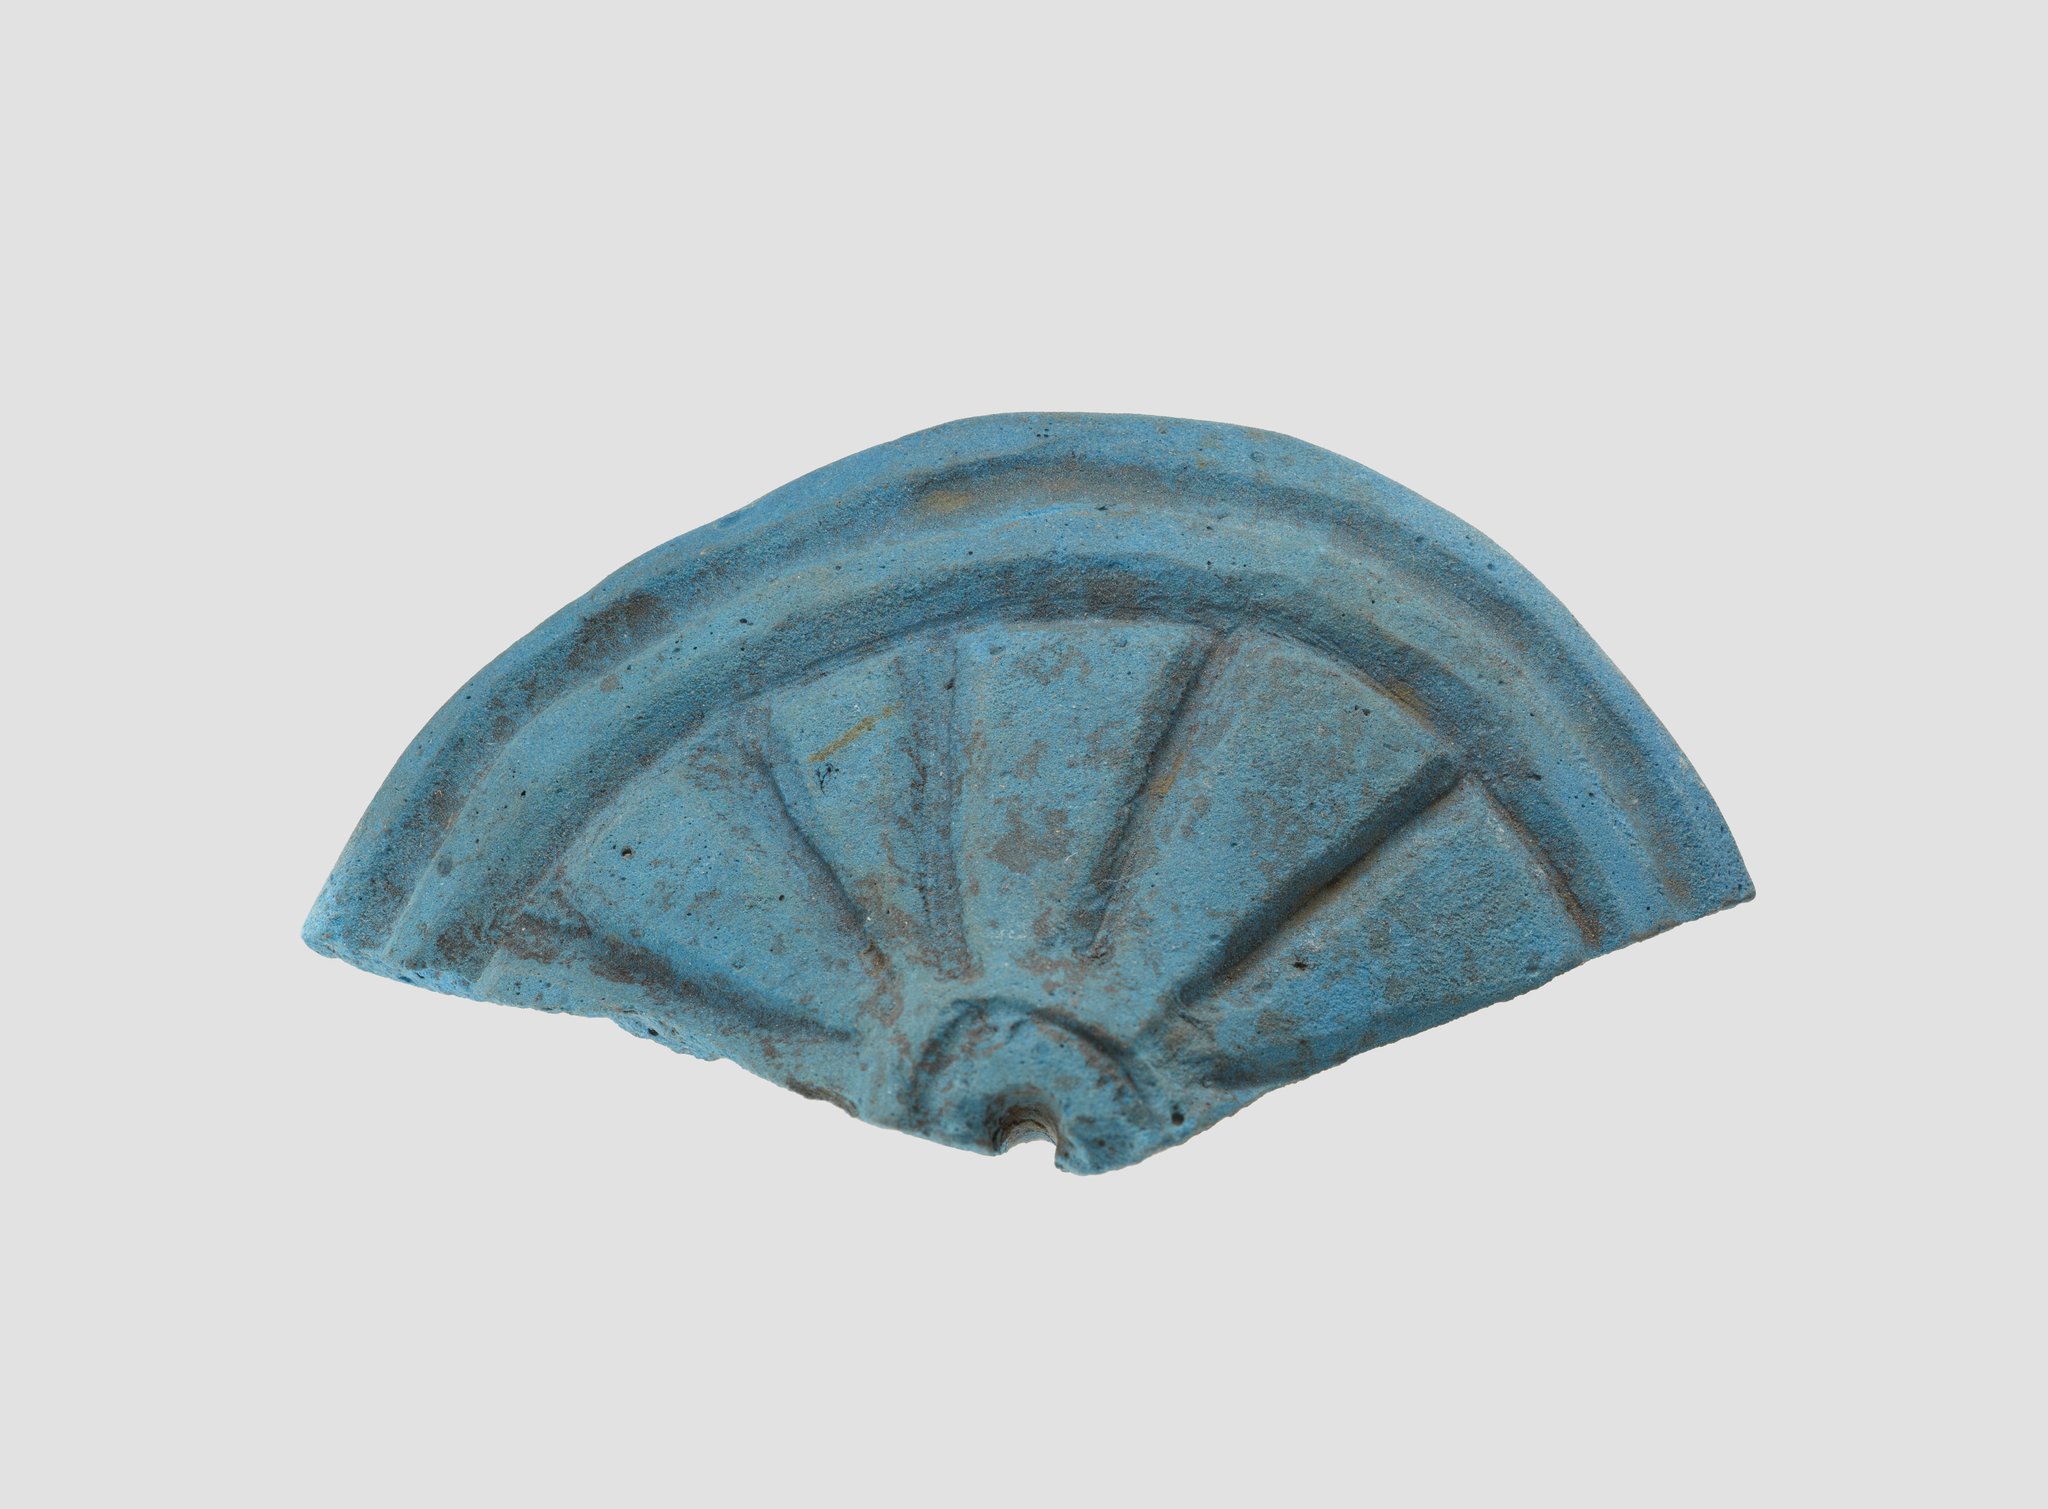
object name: bos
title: Boss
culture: iranian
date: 900-801 BCE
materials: glass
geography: iran